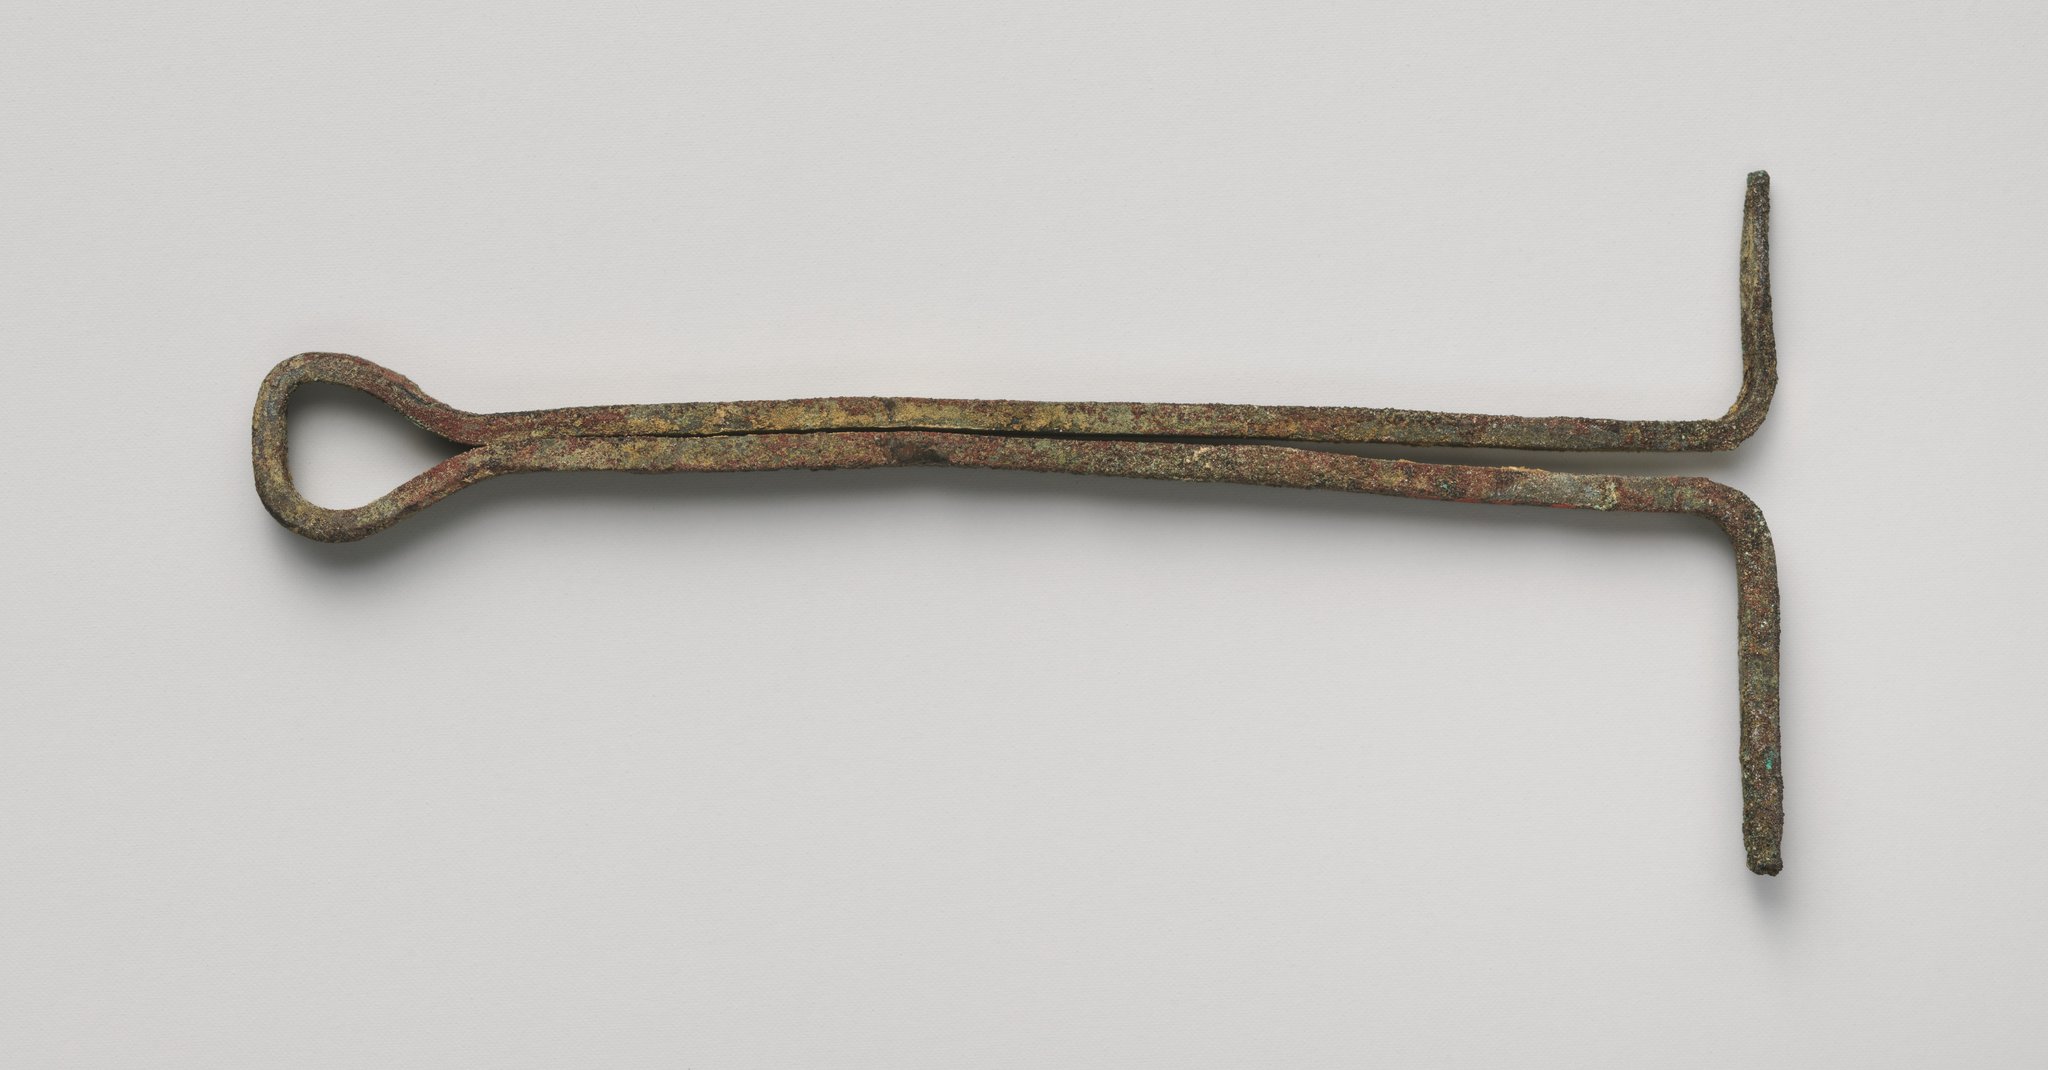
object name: tweezer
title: Tweezers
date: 306-30 BCE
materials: copper alloy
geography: egypt